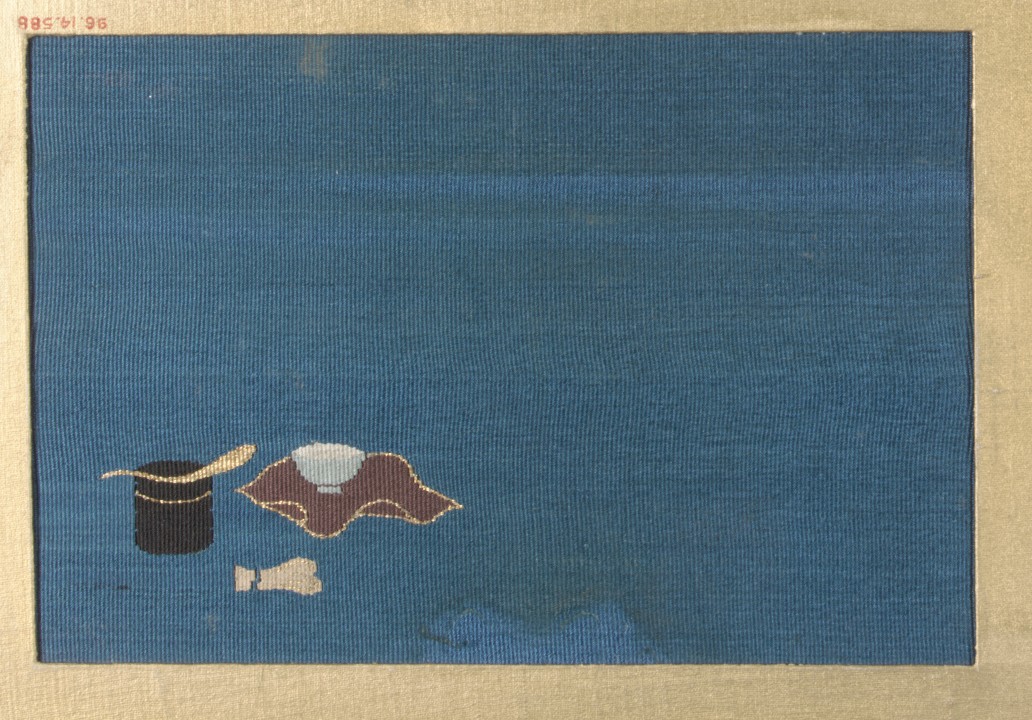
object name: piece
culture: japanese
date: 1701-1900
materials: silk